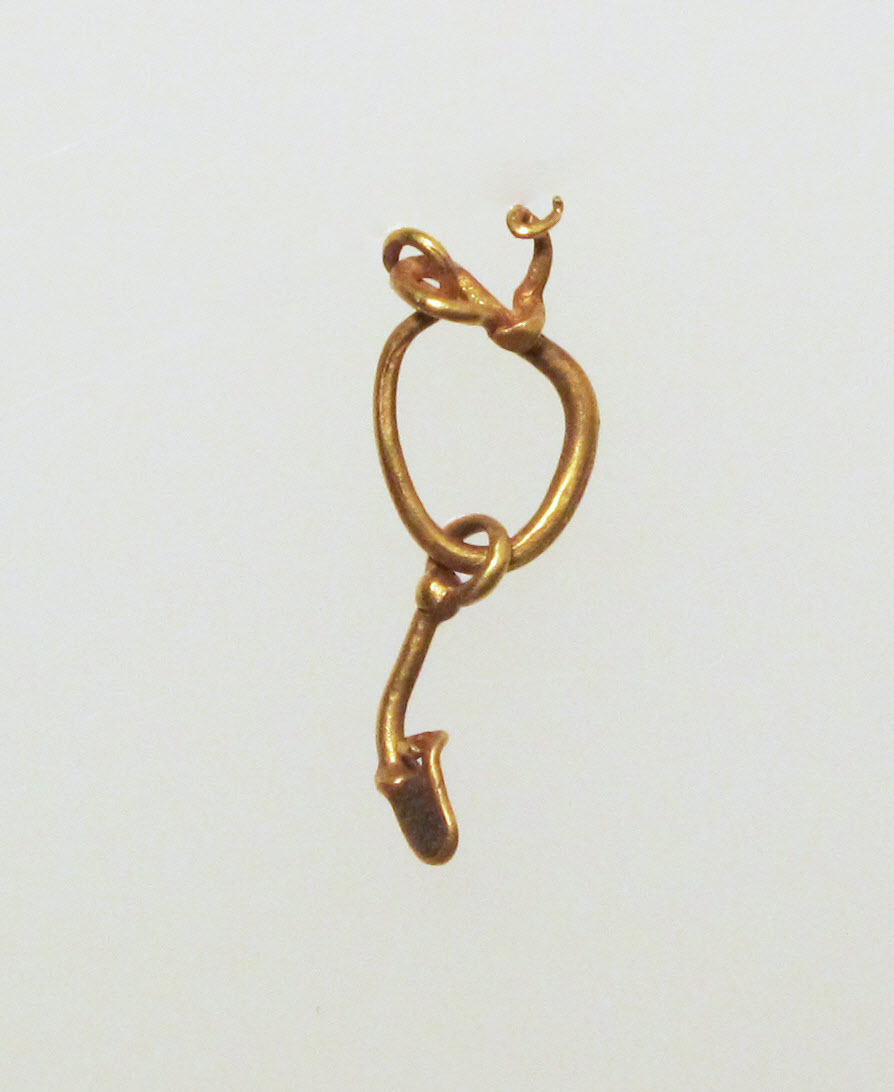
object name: earring with pendant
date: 7000 BCE-330 CE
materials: gold